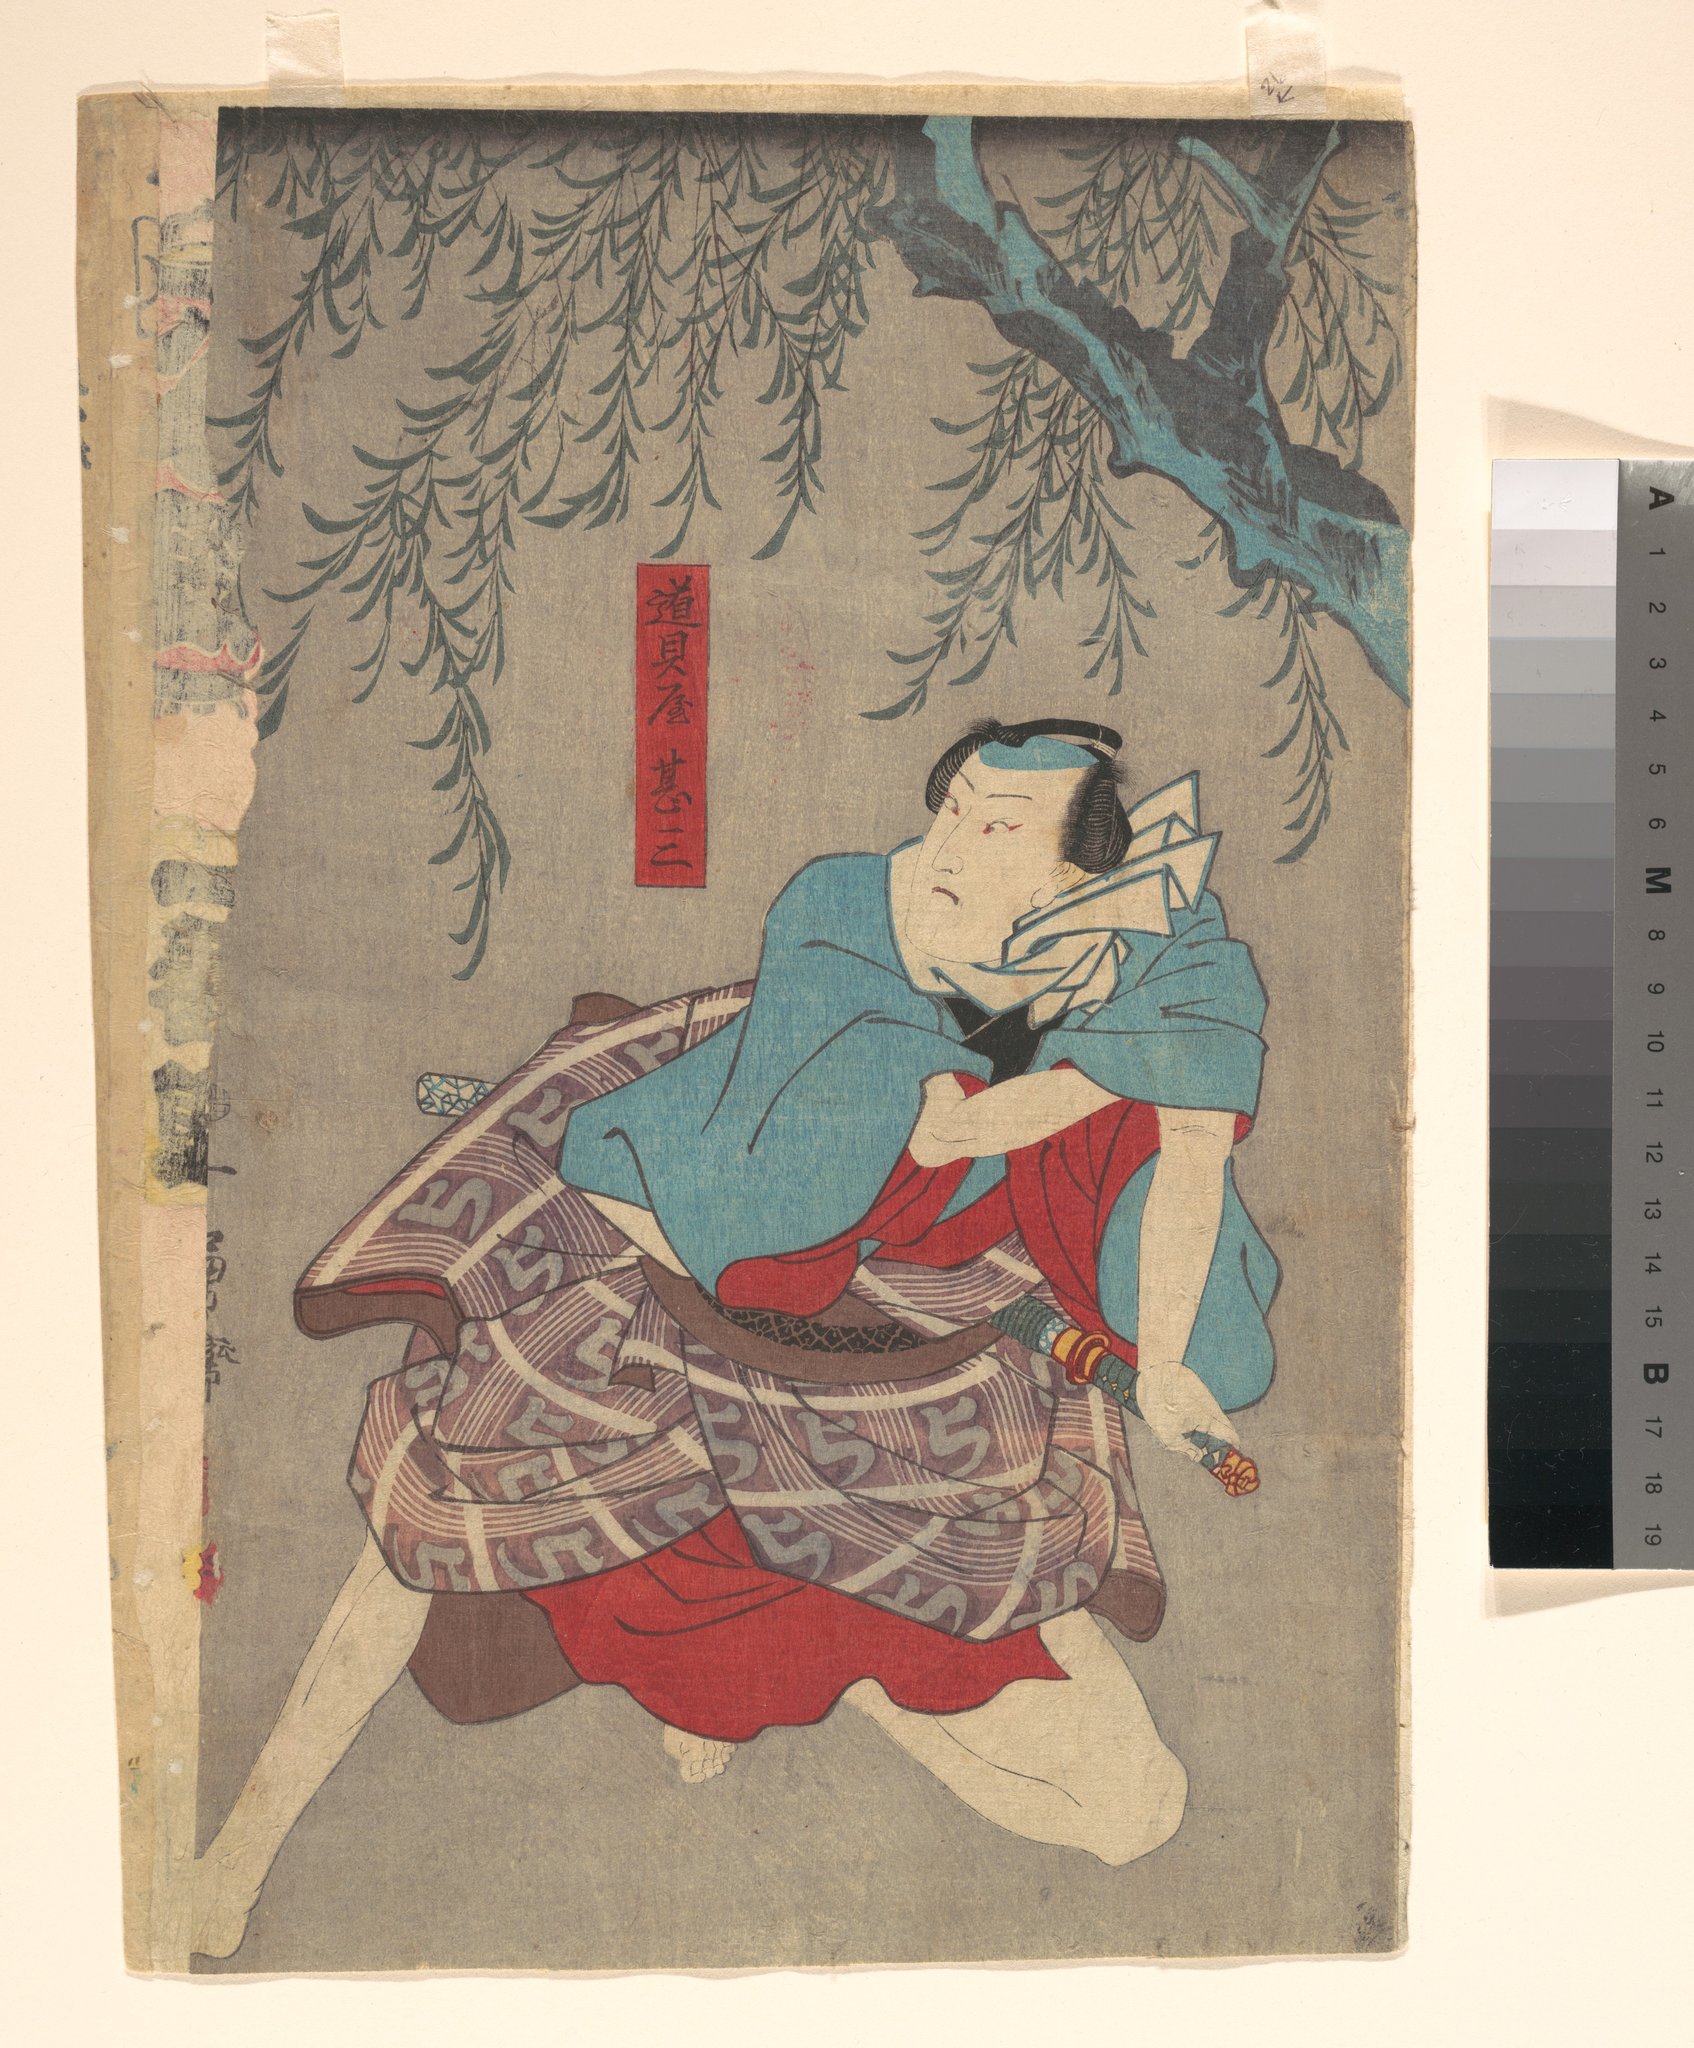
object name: print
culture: japanese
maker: utagawa kunisada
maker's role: artist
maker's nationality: japanese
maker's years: 1786-1864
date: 1801-1900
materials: ink, paper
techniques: woodblock print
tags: swords,men,trees